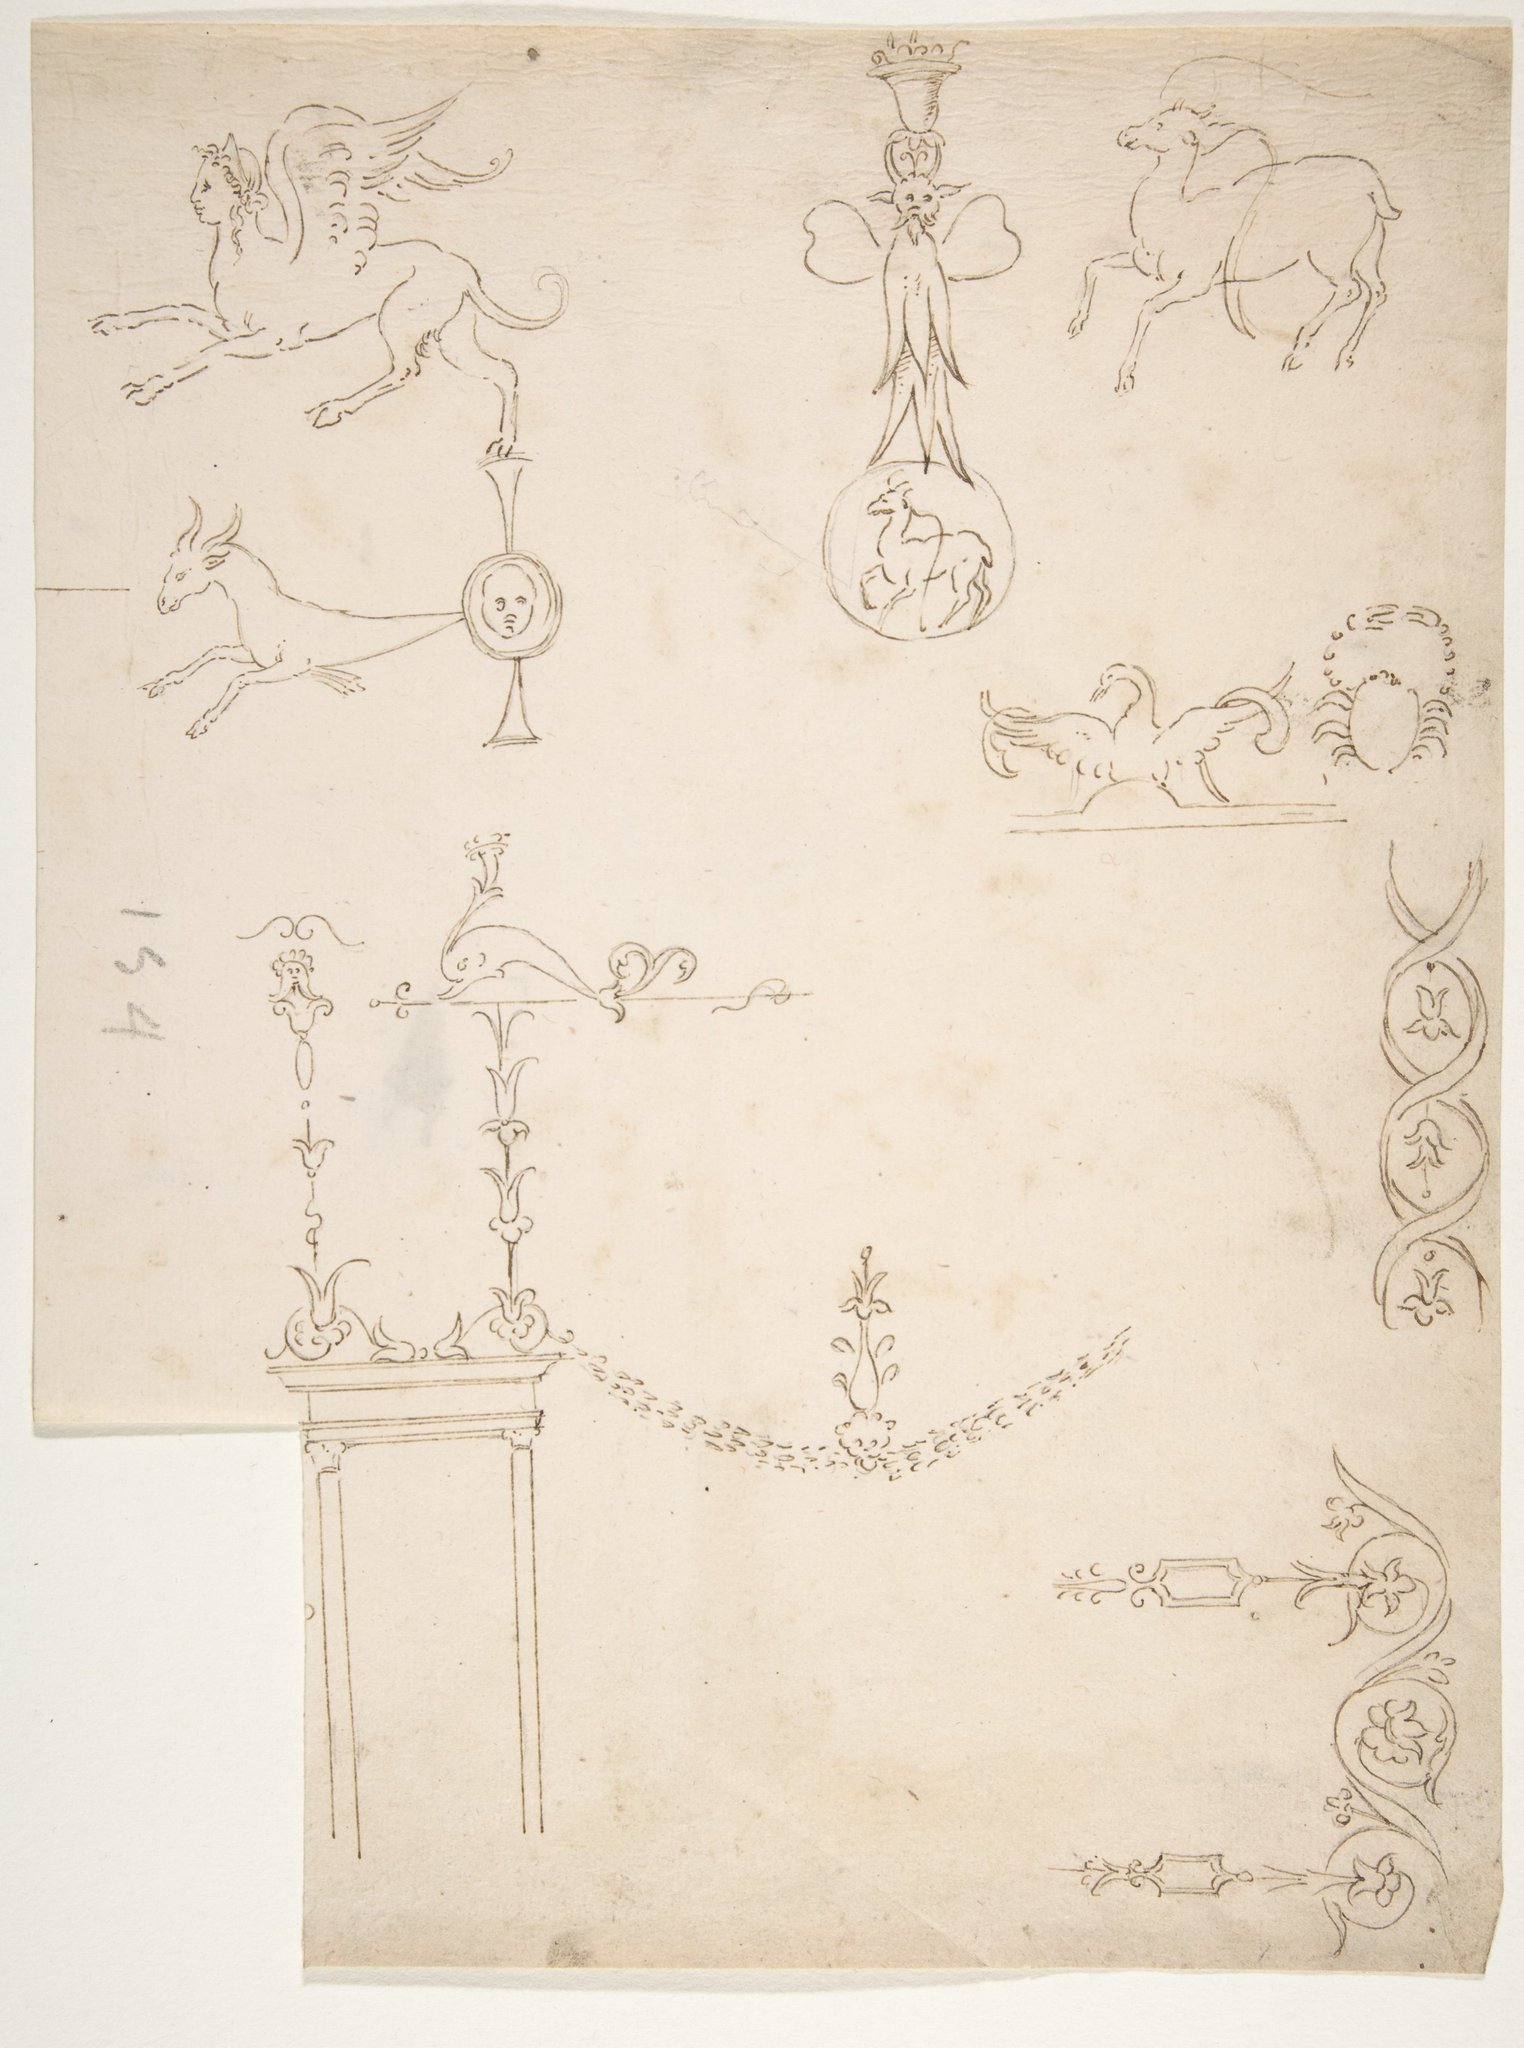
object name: collection ornament architecture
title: Domus Aurea, cryptoporticus, grotteschi, details (recto) blank (verso)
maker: anonymous, french, 16th century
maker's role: draftsman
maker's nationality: french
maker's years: 1500-1600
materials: chalk, ink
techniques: incising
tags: ornament